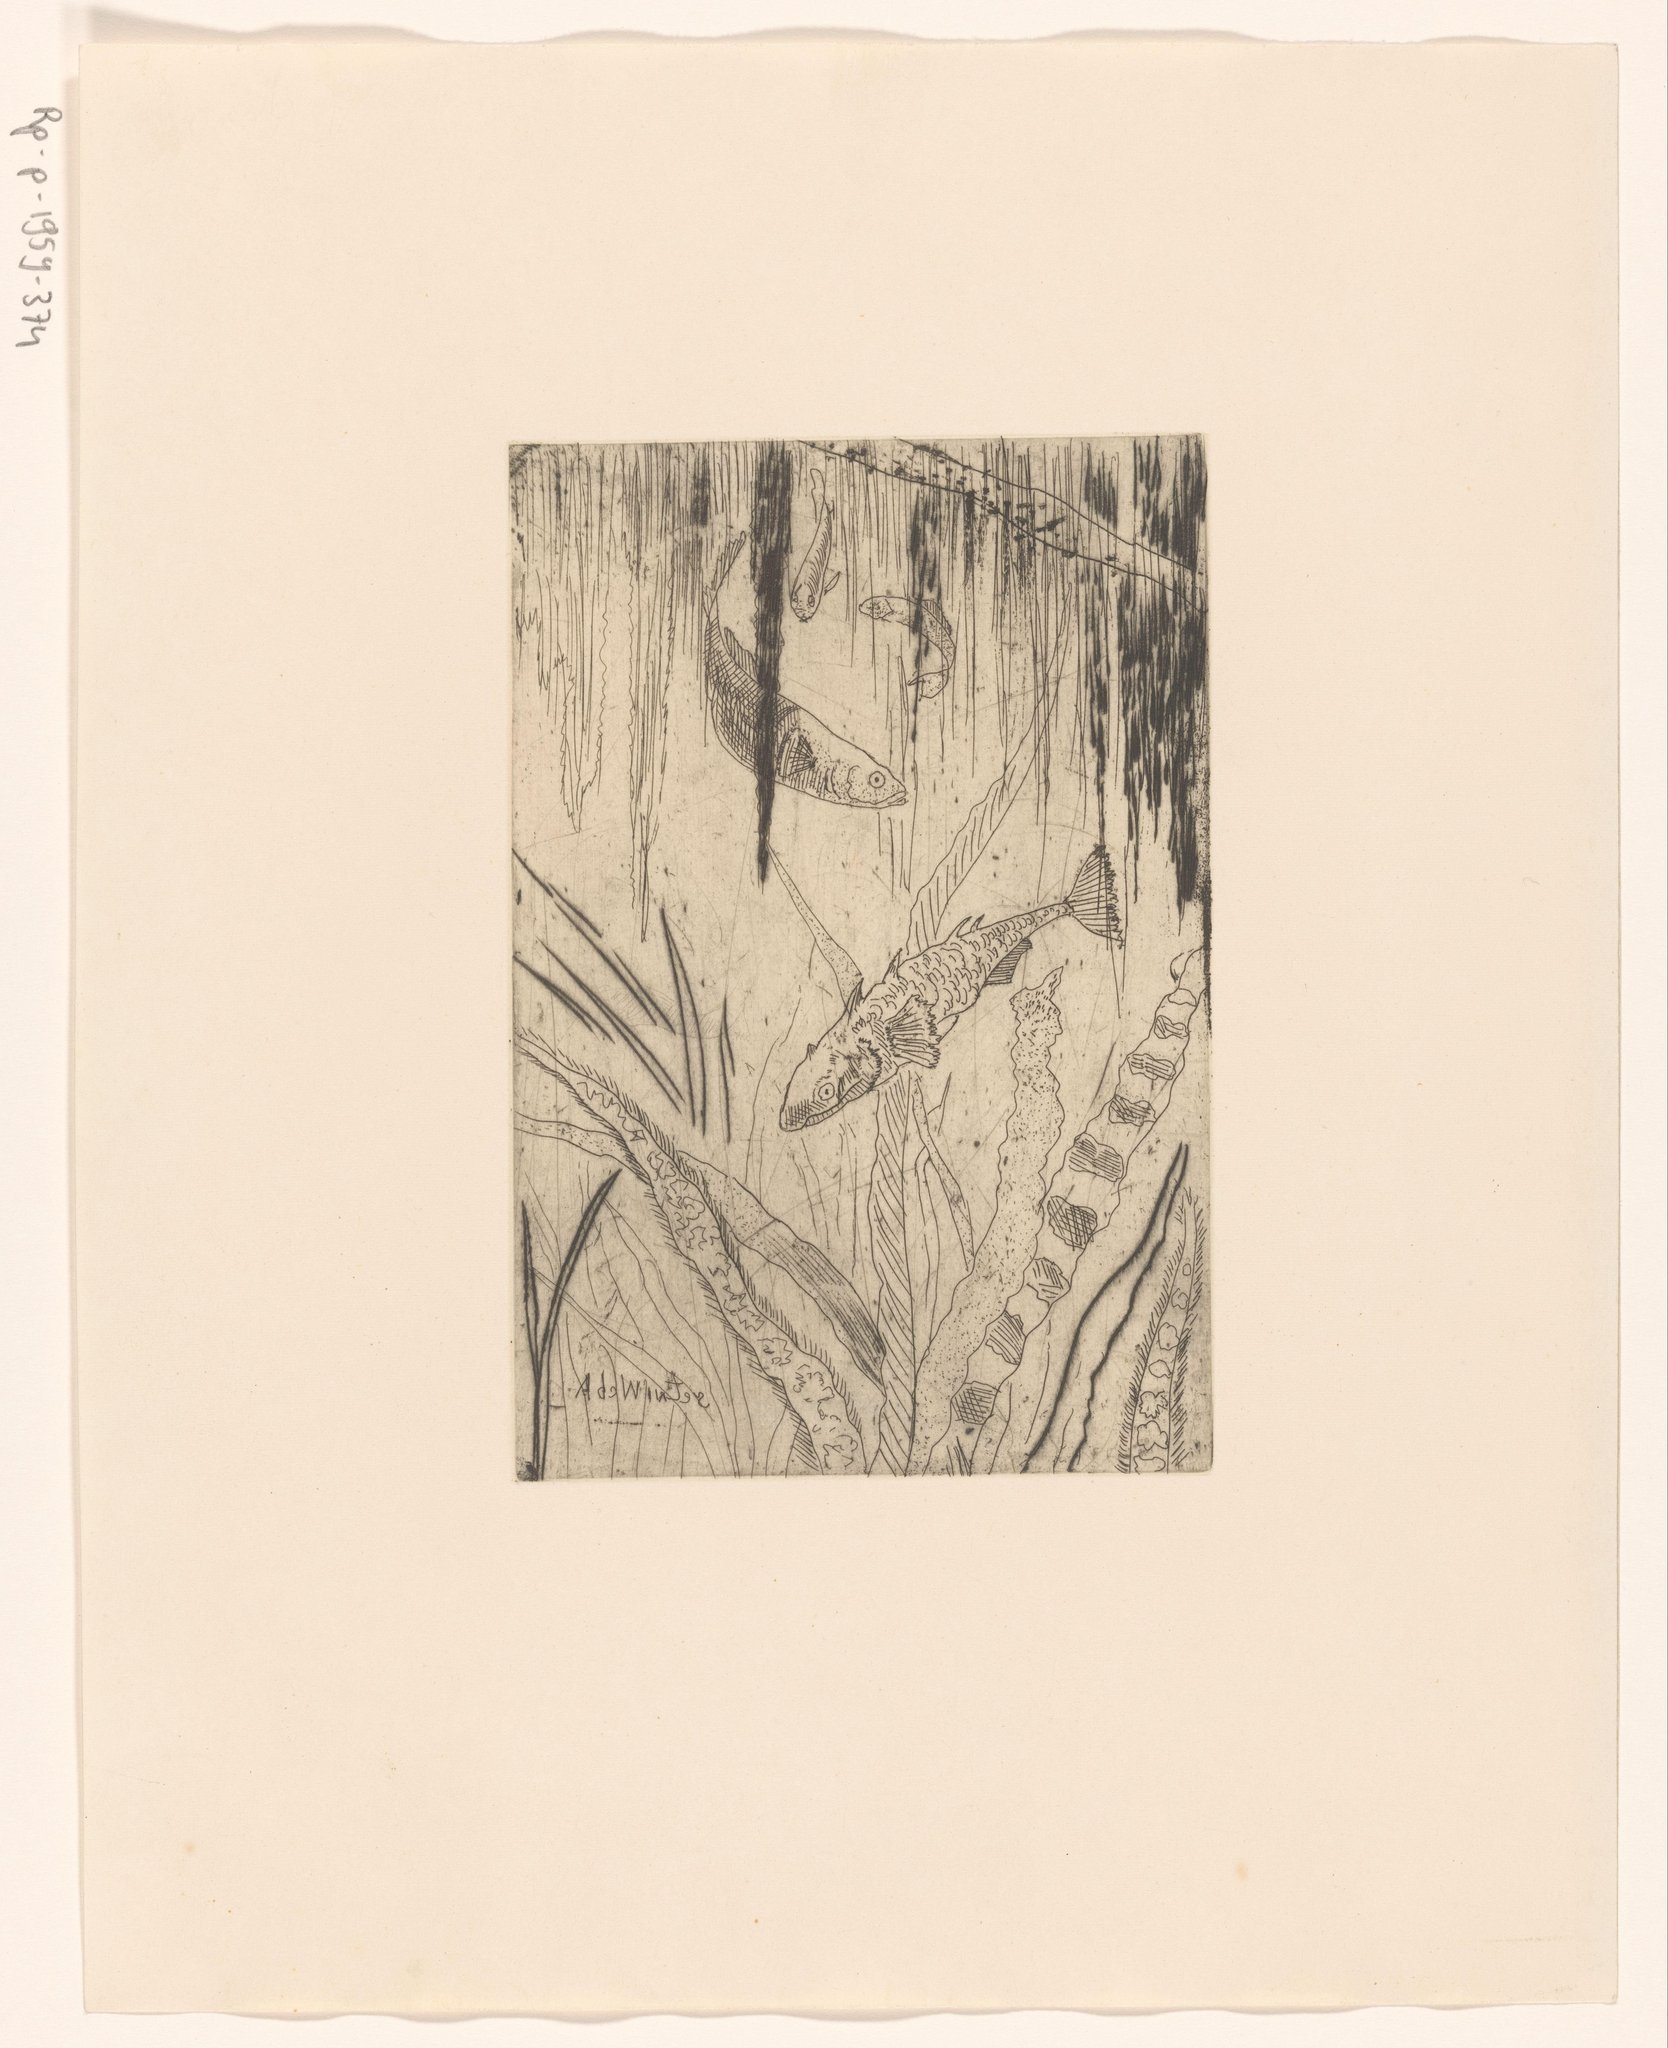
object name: print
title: Aquarium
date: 1892-1951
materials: paper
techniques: drypoint, etching, intaglio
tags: fishes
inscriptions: collector's mark: Lugt 2228